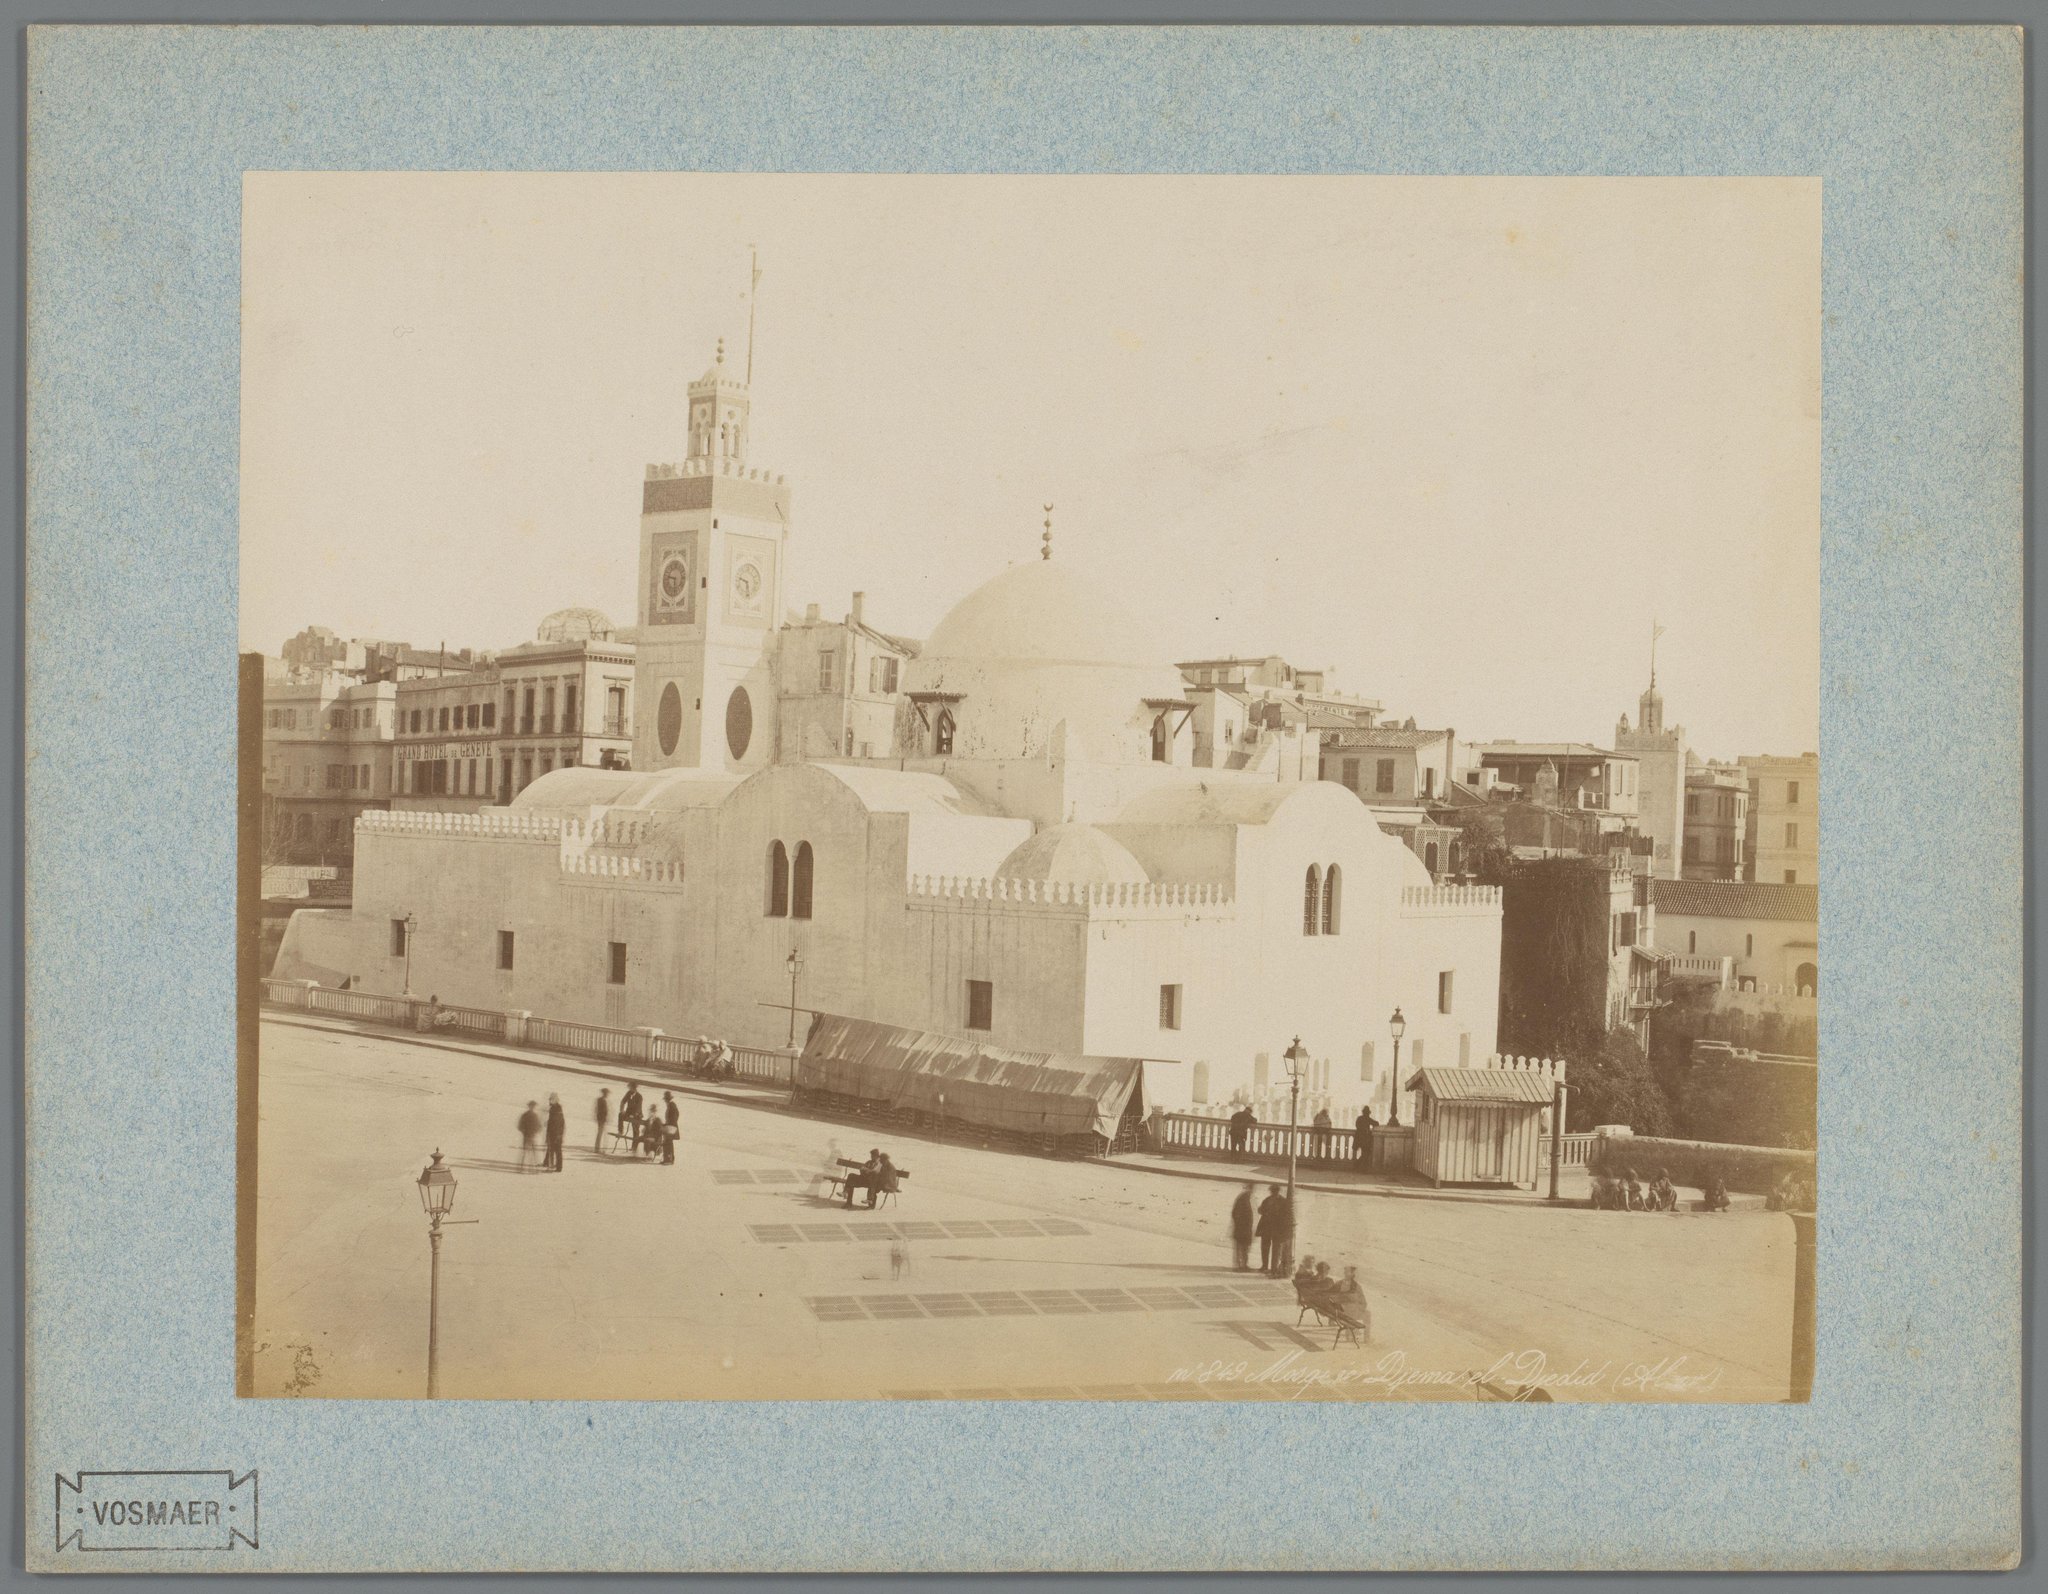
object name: photograph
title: Gezicht op de Djama'a el Djedid-moskee in Algiers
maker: Anonymous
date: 1851-1900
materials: cardboard, paper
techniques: albumen print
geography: algiers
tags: temple, shrine ~ islam, mohammedanism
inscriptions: number: ‘N 849’, collector's mark: ‘VOSMAER’